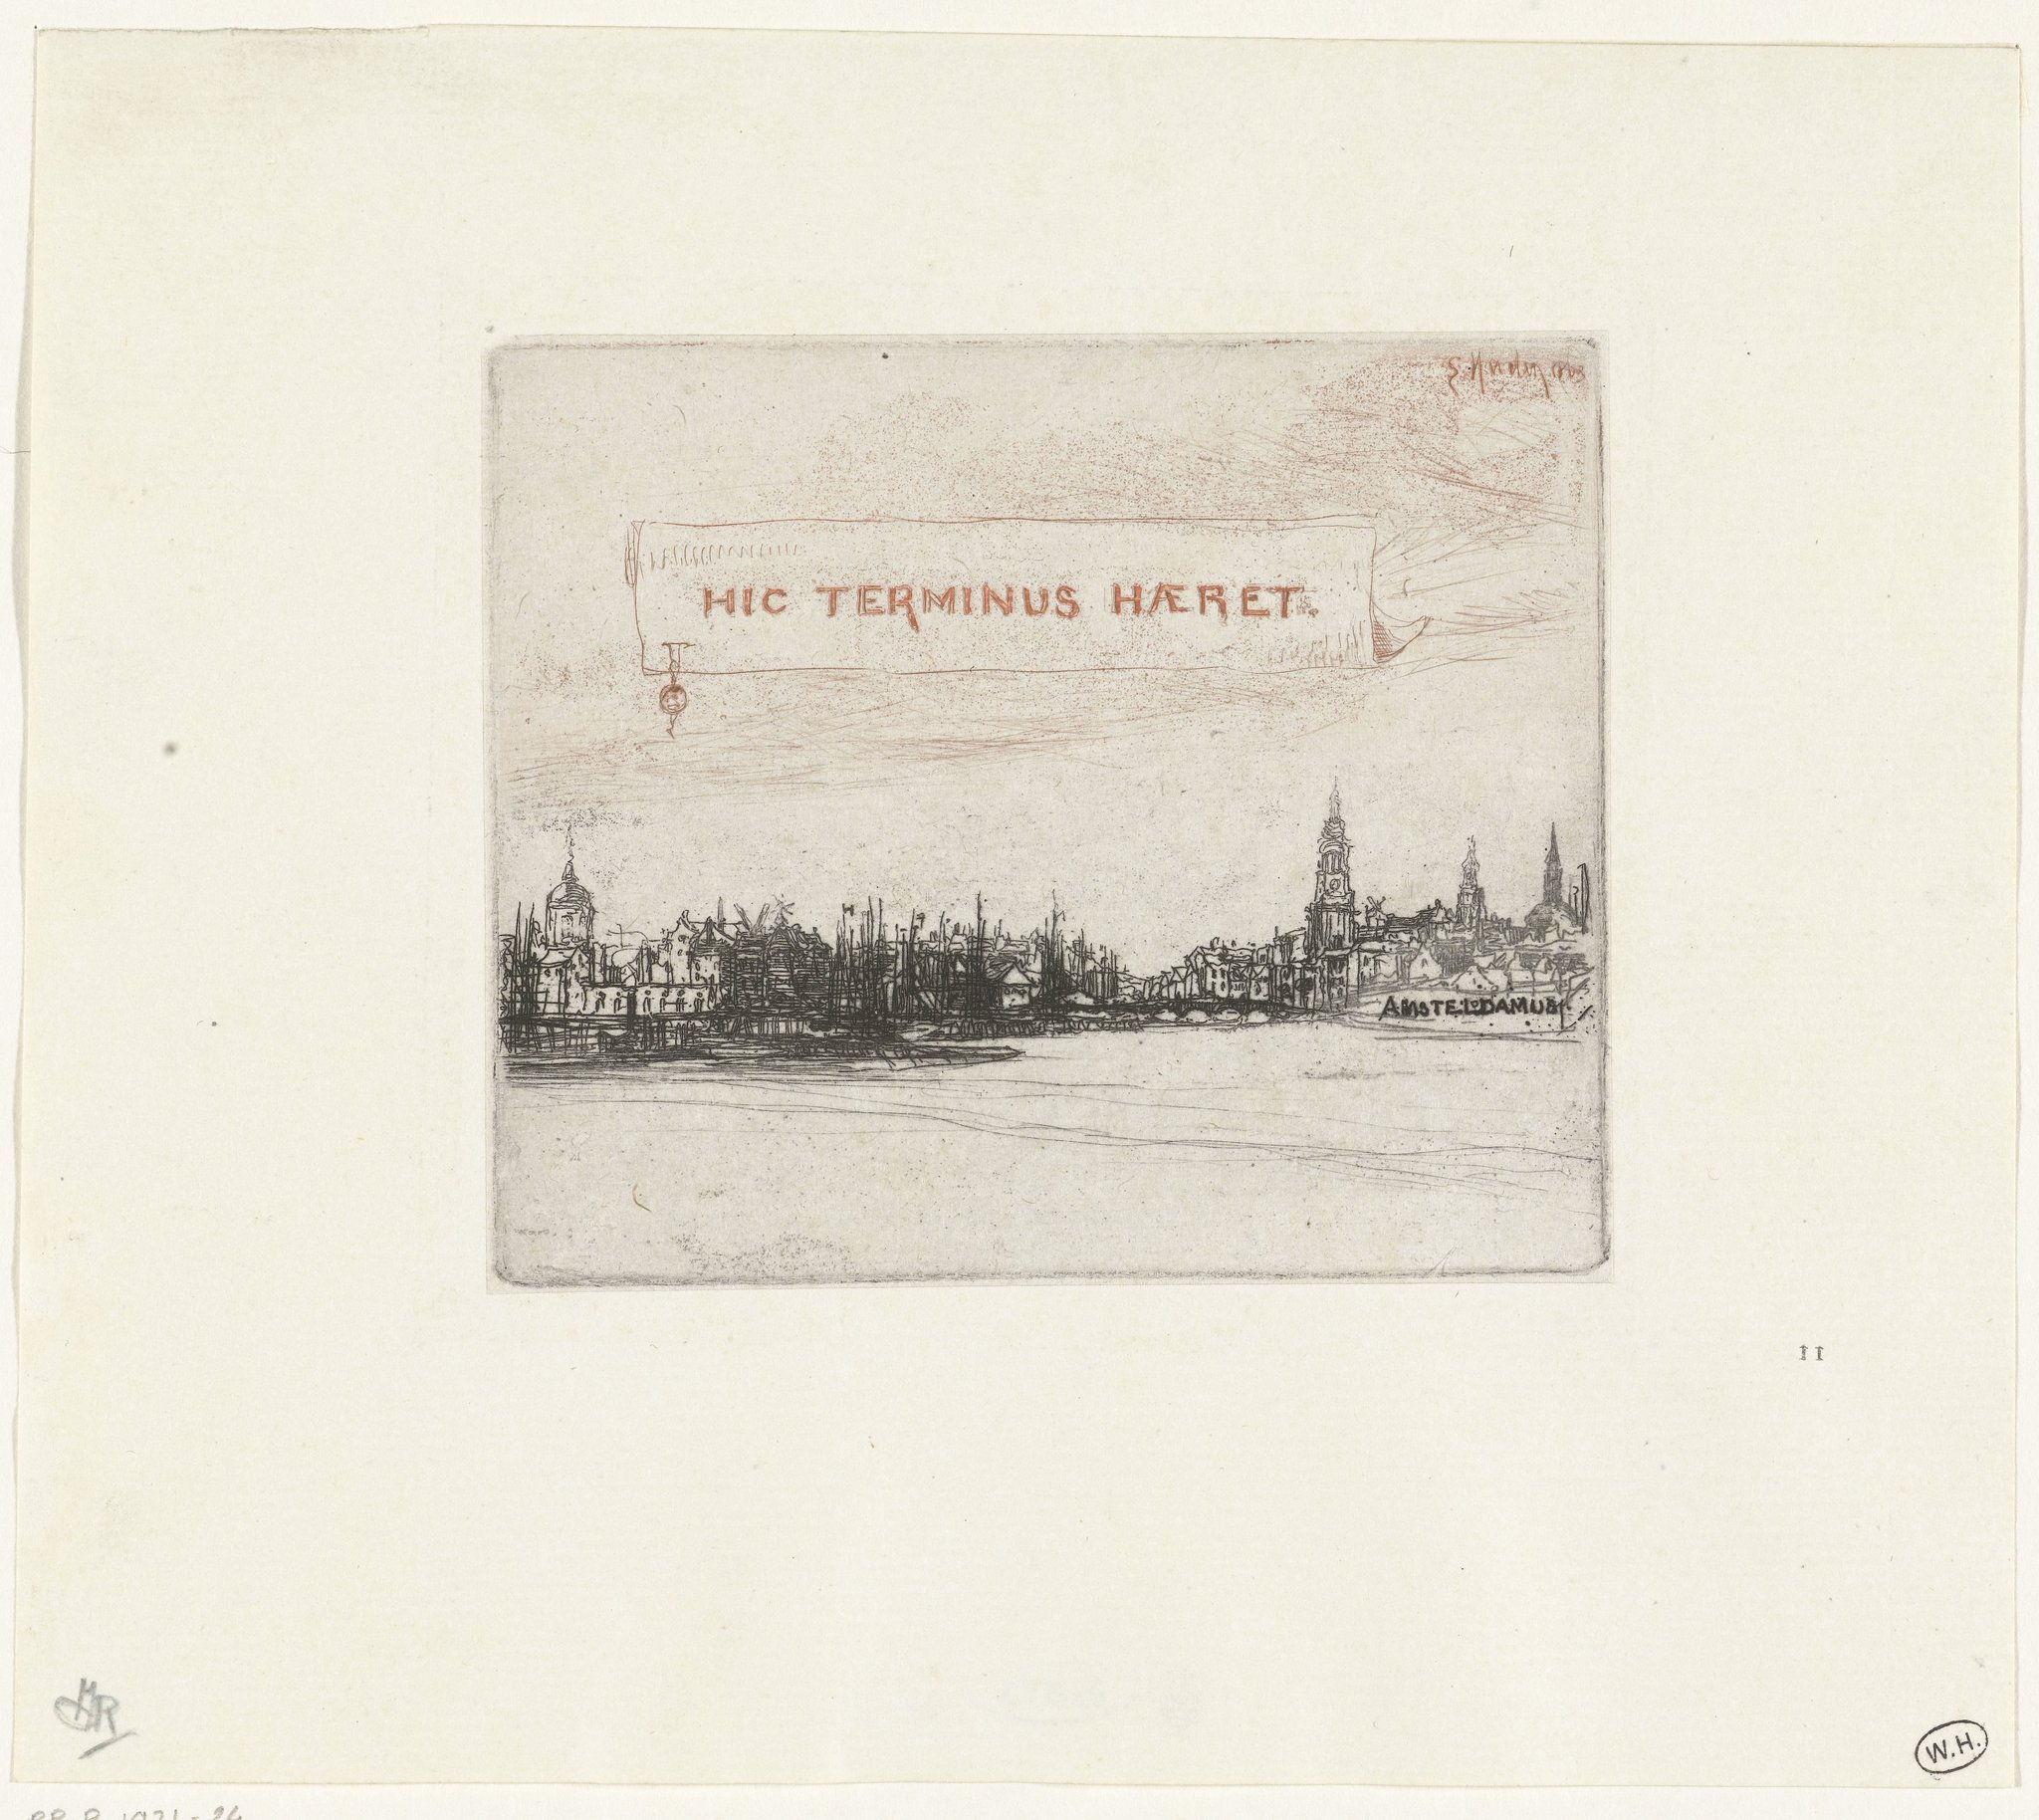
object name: print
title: Gezicht op Amsterdam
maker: francis seymour-haden (sir)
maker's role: print maker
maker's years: 1818-1910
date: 1863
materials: paper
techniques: etching, lithography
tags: city-view in general; 'veduta', amsterdam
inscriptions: collector's mark: Lugt 2624, collector's mark: Lugt 2228, collector's mark: Lugt 2760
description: Gezicht op de stad Amsterdam vanaf het IJ. Boven het stadgezicht een blad papier, met een zegel in de linkerhoek en de tekst "Hic terminus haeret".